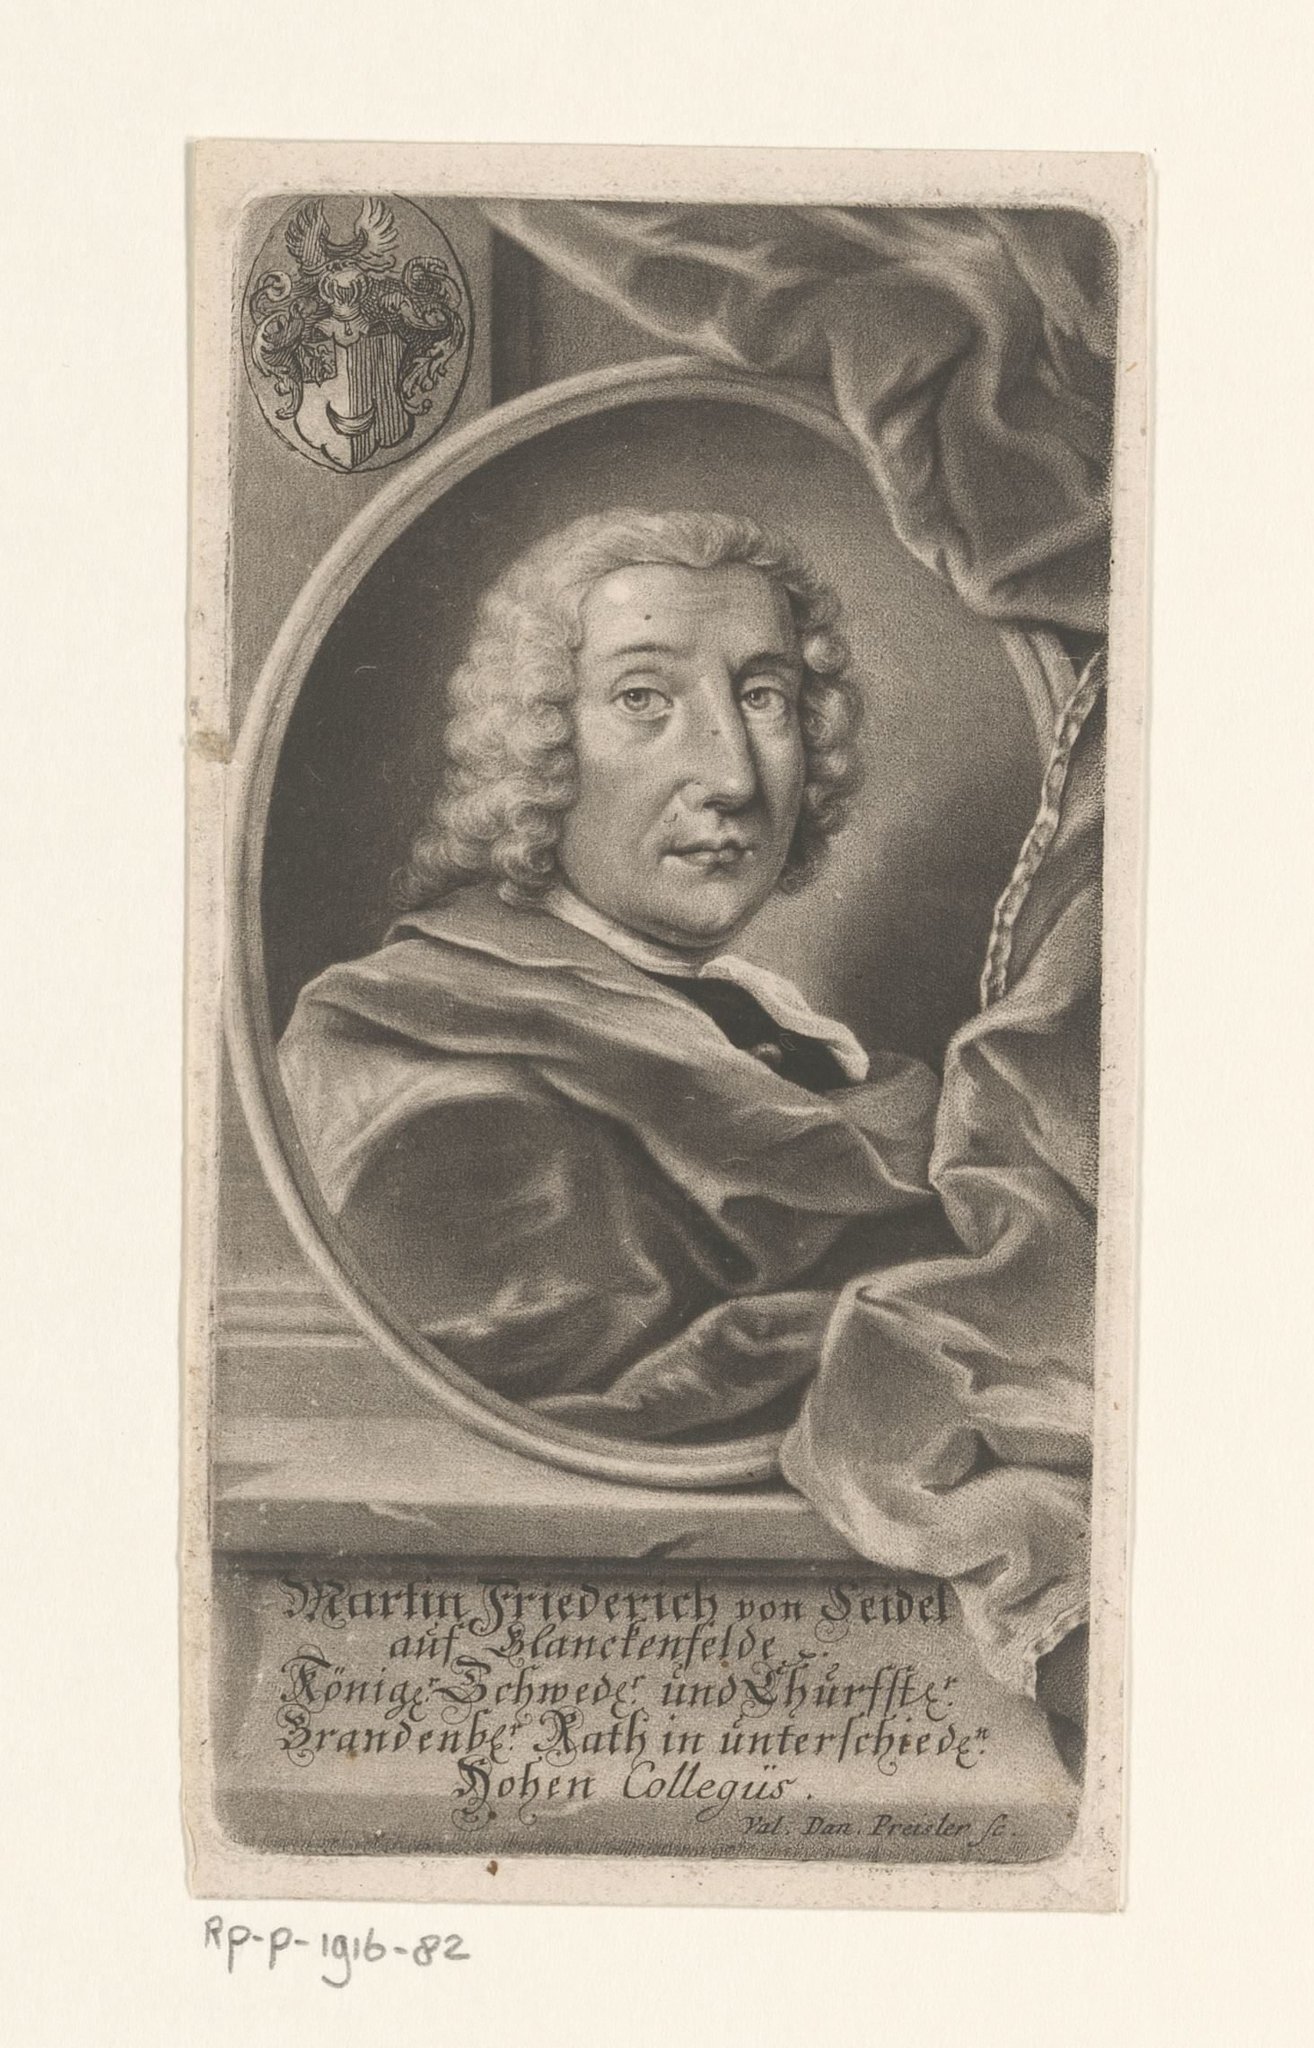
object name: print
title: Portret van Martin Friedrich Seidel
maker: valentin daniel preissler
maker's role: print maker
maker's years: 1717-1765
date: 1727-1765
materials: paper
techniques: etching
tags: berlin, martin friedrich seidel, historical persons, armorial bearing, heraldry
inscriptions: collector's mark: Lugt 2228